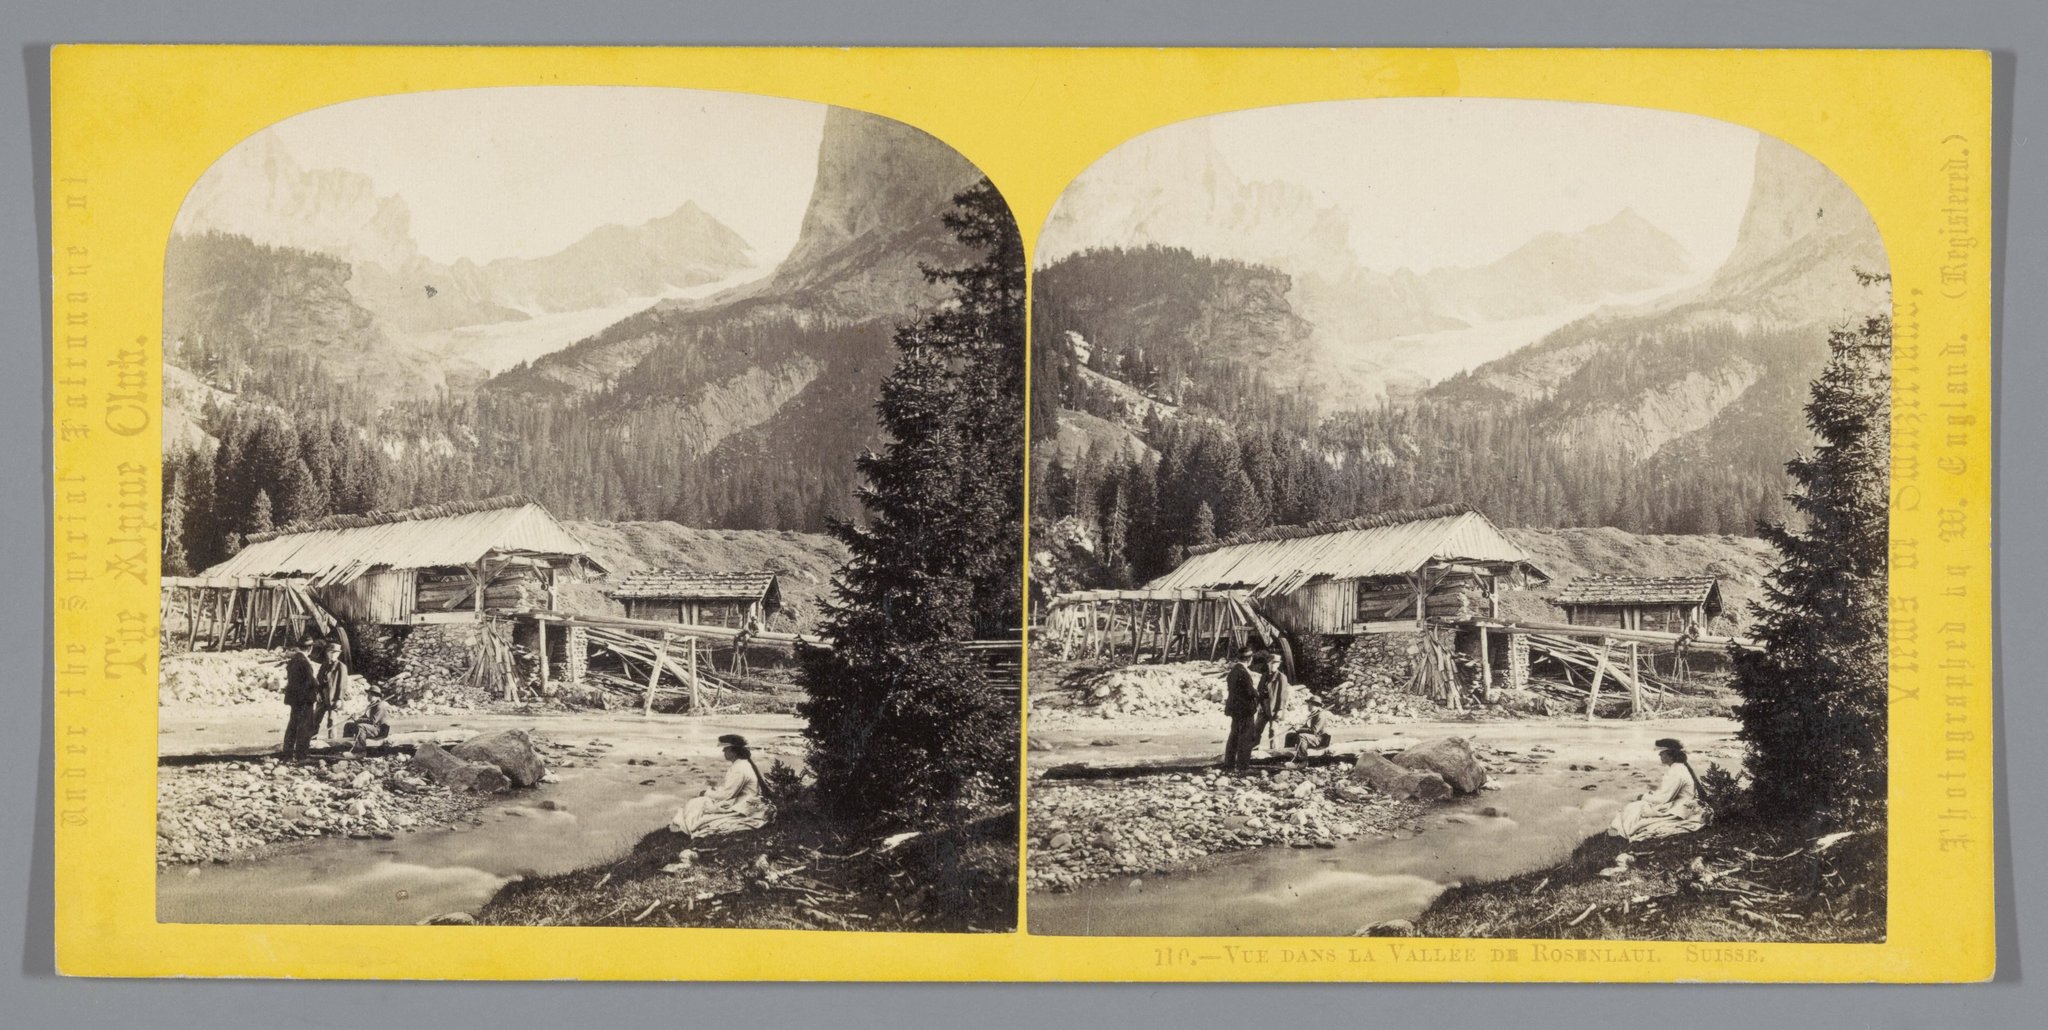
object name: stereograph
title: Vue dans la Vallée de Rosenlaui. Suisse.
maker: william england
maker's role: fotograaf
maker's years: 1816-1896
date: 1850-1880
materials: cardboard, photographic support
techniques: albumen print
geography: bern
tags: dale, valley, façade (of house or building)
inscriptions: number: ‘110.’, inscription: ‘Views of Switzerland, photographed by W. England. (Registered) Under the Special Patronage of the Alpine Club.’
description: De objecten RP-F-F08073 en RP-F-F08074 zijn vermoedelijk tijdens dezelfde fotografeersessie gemaakt.